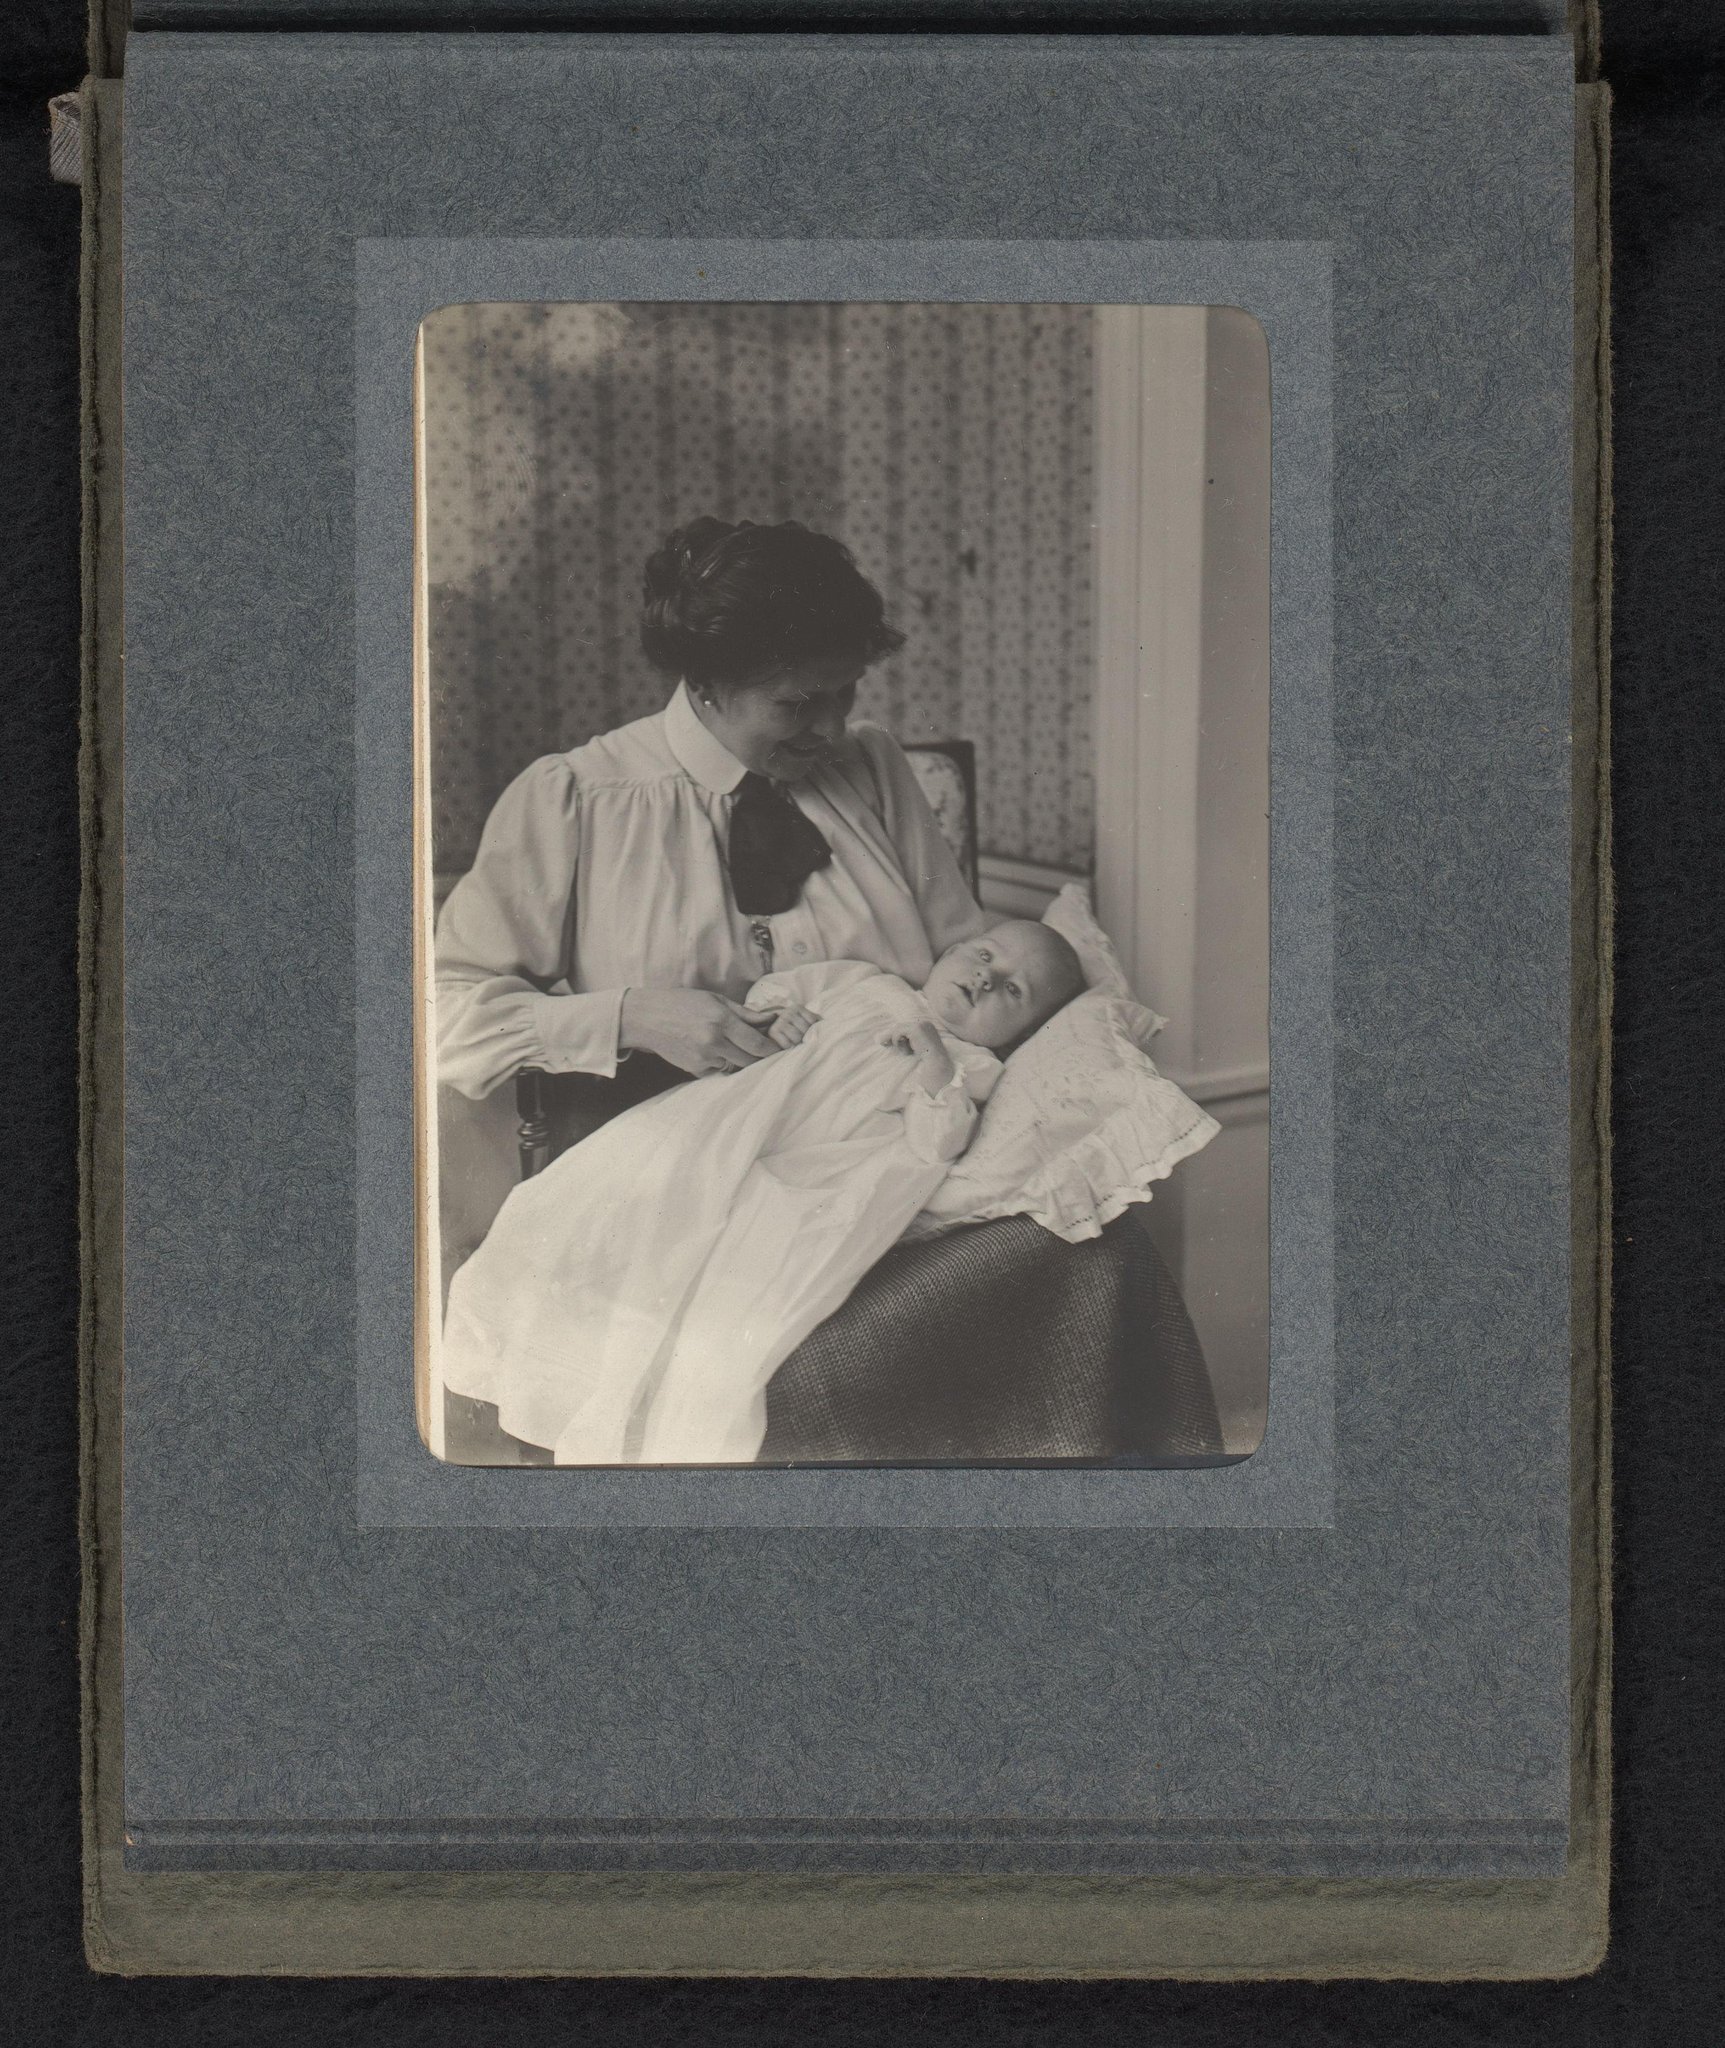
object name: album leaf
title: Caroline van den Berg met baby Frank op schoot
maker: hendrik herman van den berg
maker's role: amateurfotograaf, jurist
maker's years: 1875-1944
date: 1912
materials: paper, cardboard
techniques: gelatin silver print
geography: amsterdam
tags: the hague, caroline louise van den berg-van den berg, amsterdam, frank willem van den berg (1912-1998), historical persons, mother and baby or young child, infant, baby